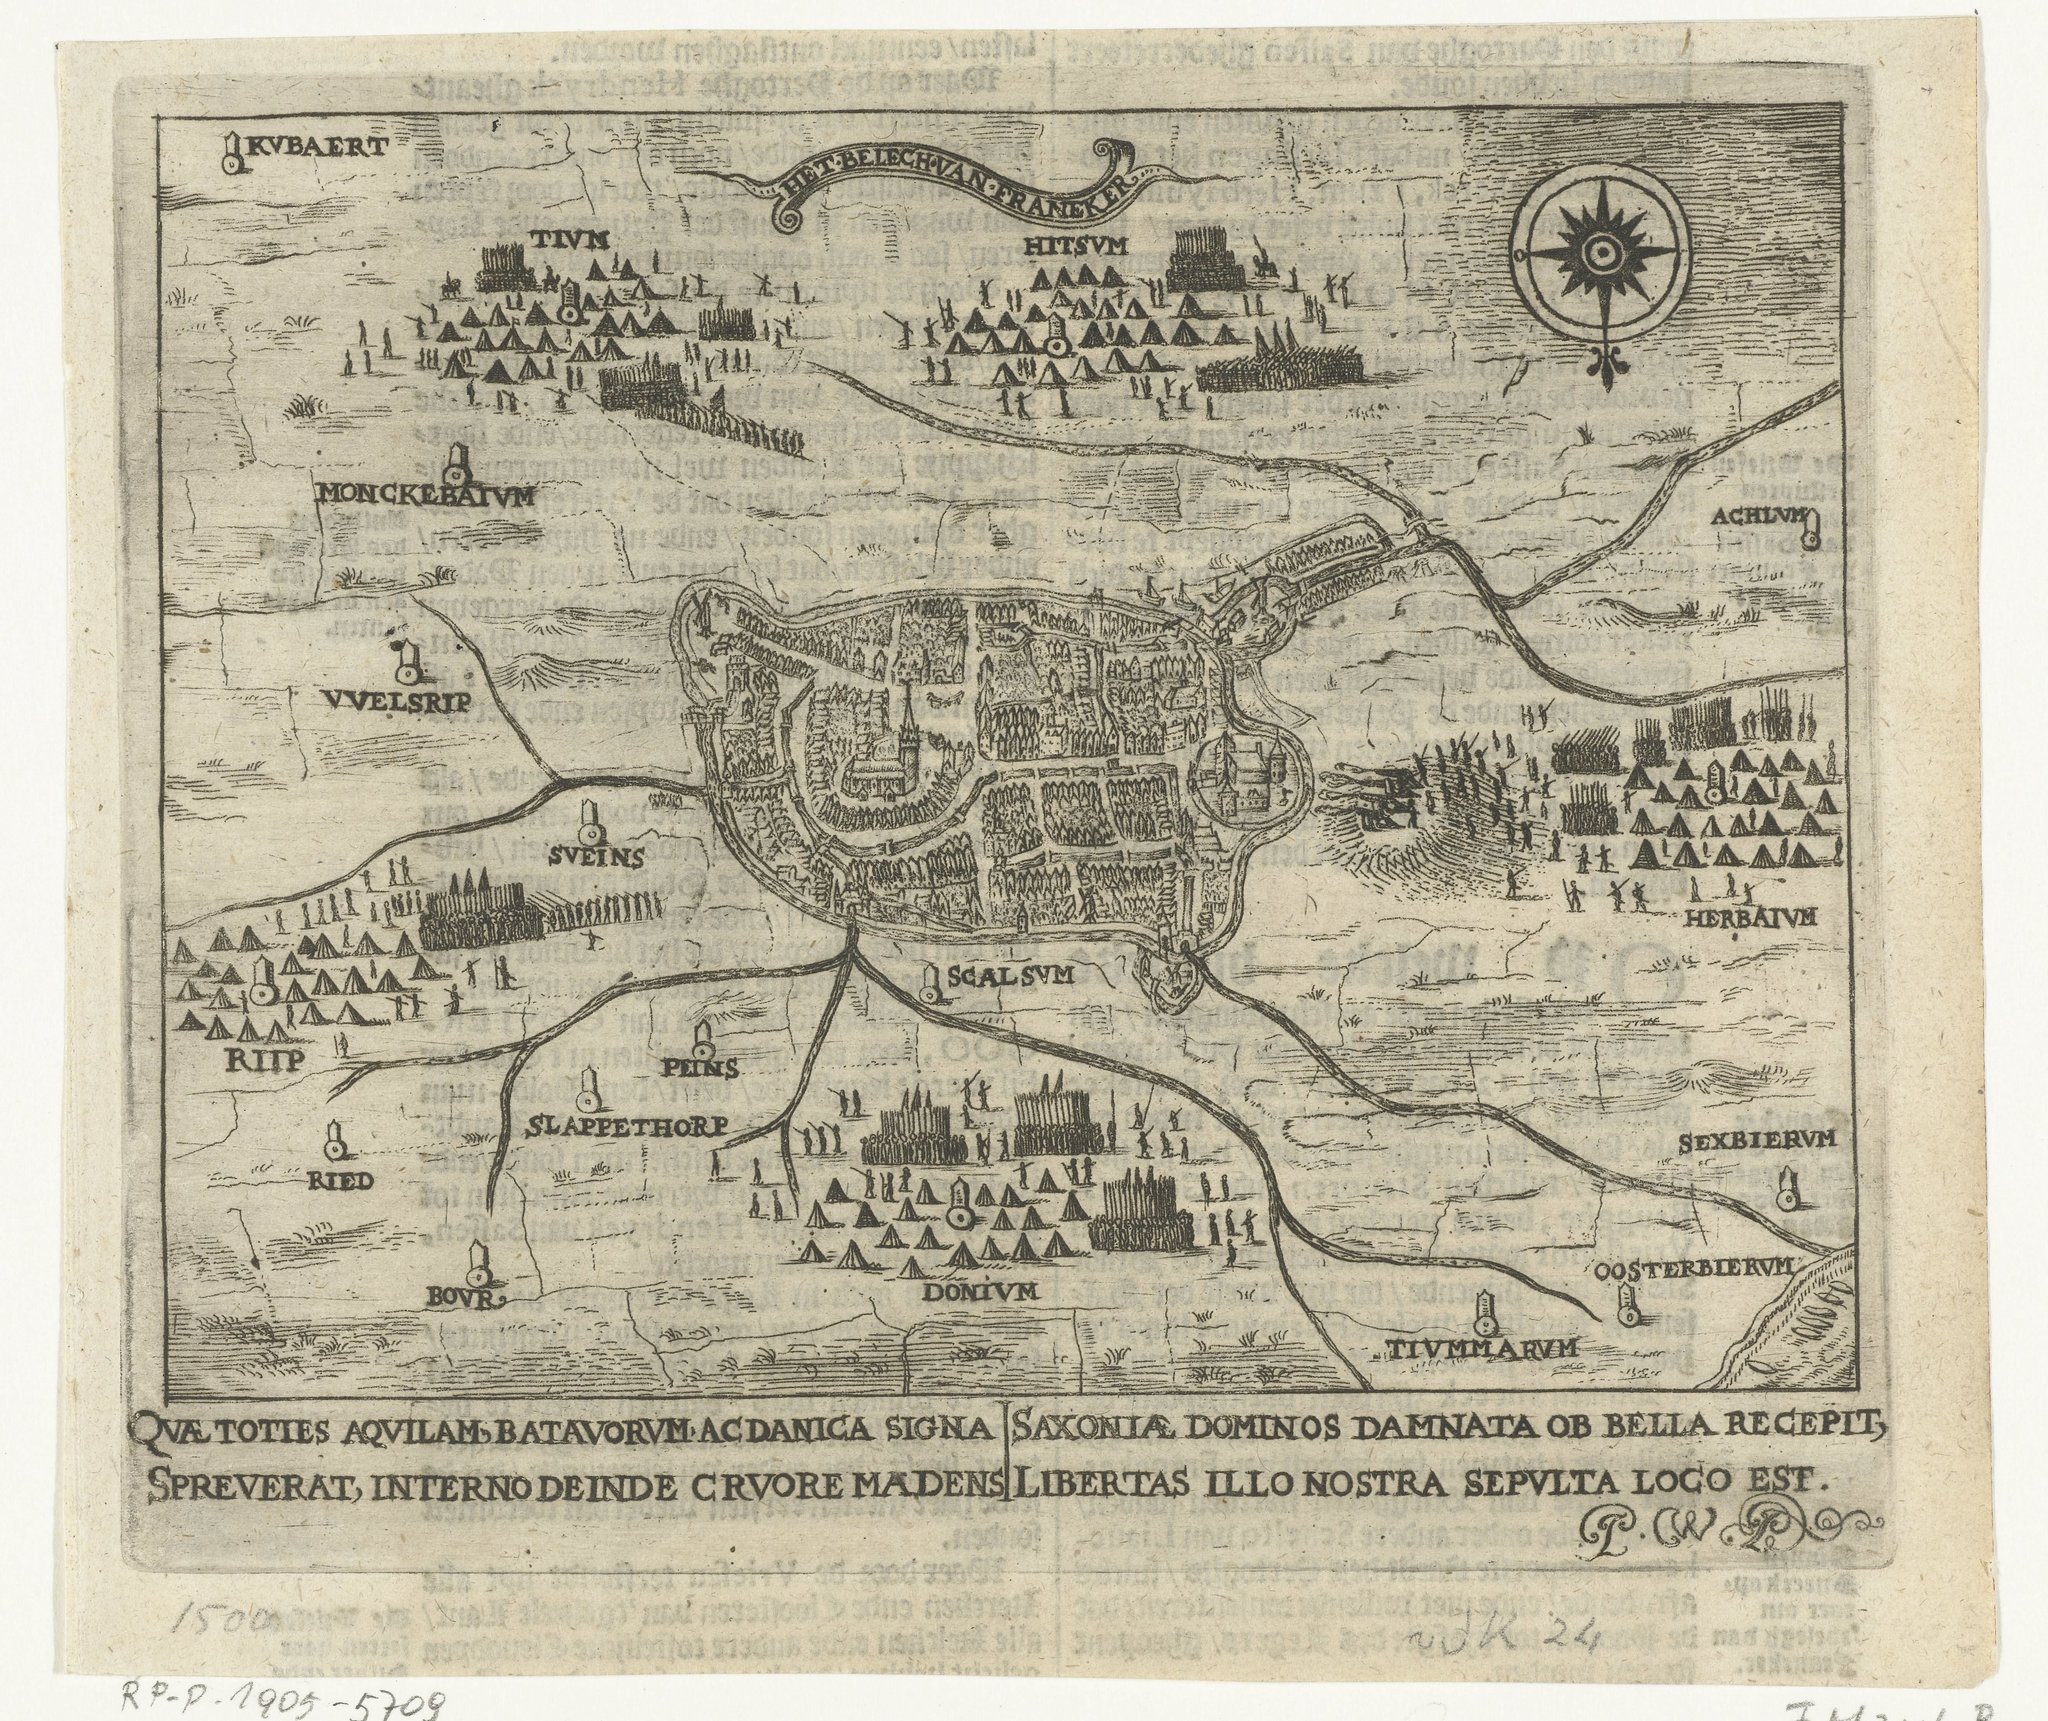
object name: print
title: Beleg van Franeker, 1500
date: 1620-1622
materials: paper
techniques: etching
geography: northern netherlands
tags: maps of separate countries or regions, siege, position war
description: Plattegrond van het beleg van het door de Saksen bezette Franeker door 16000 Friezen onder aanvoering van Friese edelen Avlya, Borga en anderen, 12 mei - 16 juli 1500. Kaartje met de ligging van de Friese legers en de Latijnse namen van omringende dorpen. Met onderschrift van twee regels in het Latijn. Nederlandse tekst op achterzijde.